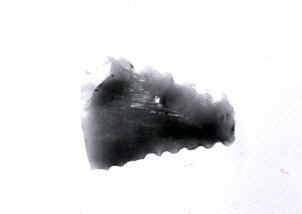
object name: arrowhead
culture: sasanian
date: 201-700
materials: stone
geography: iran